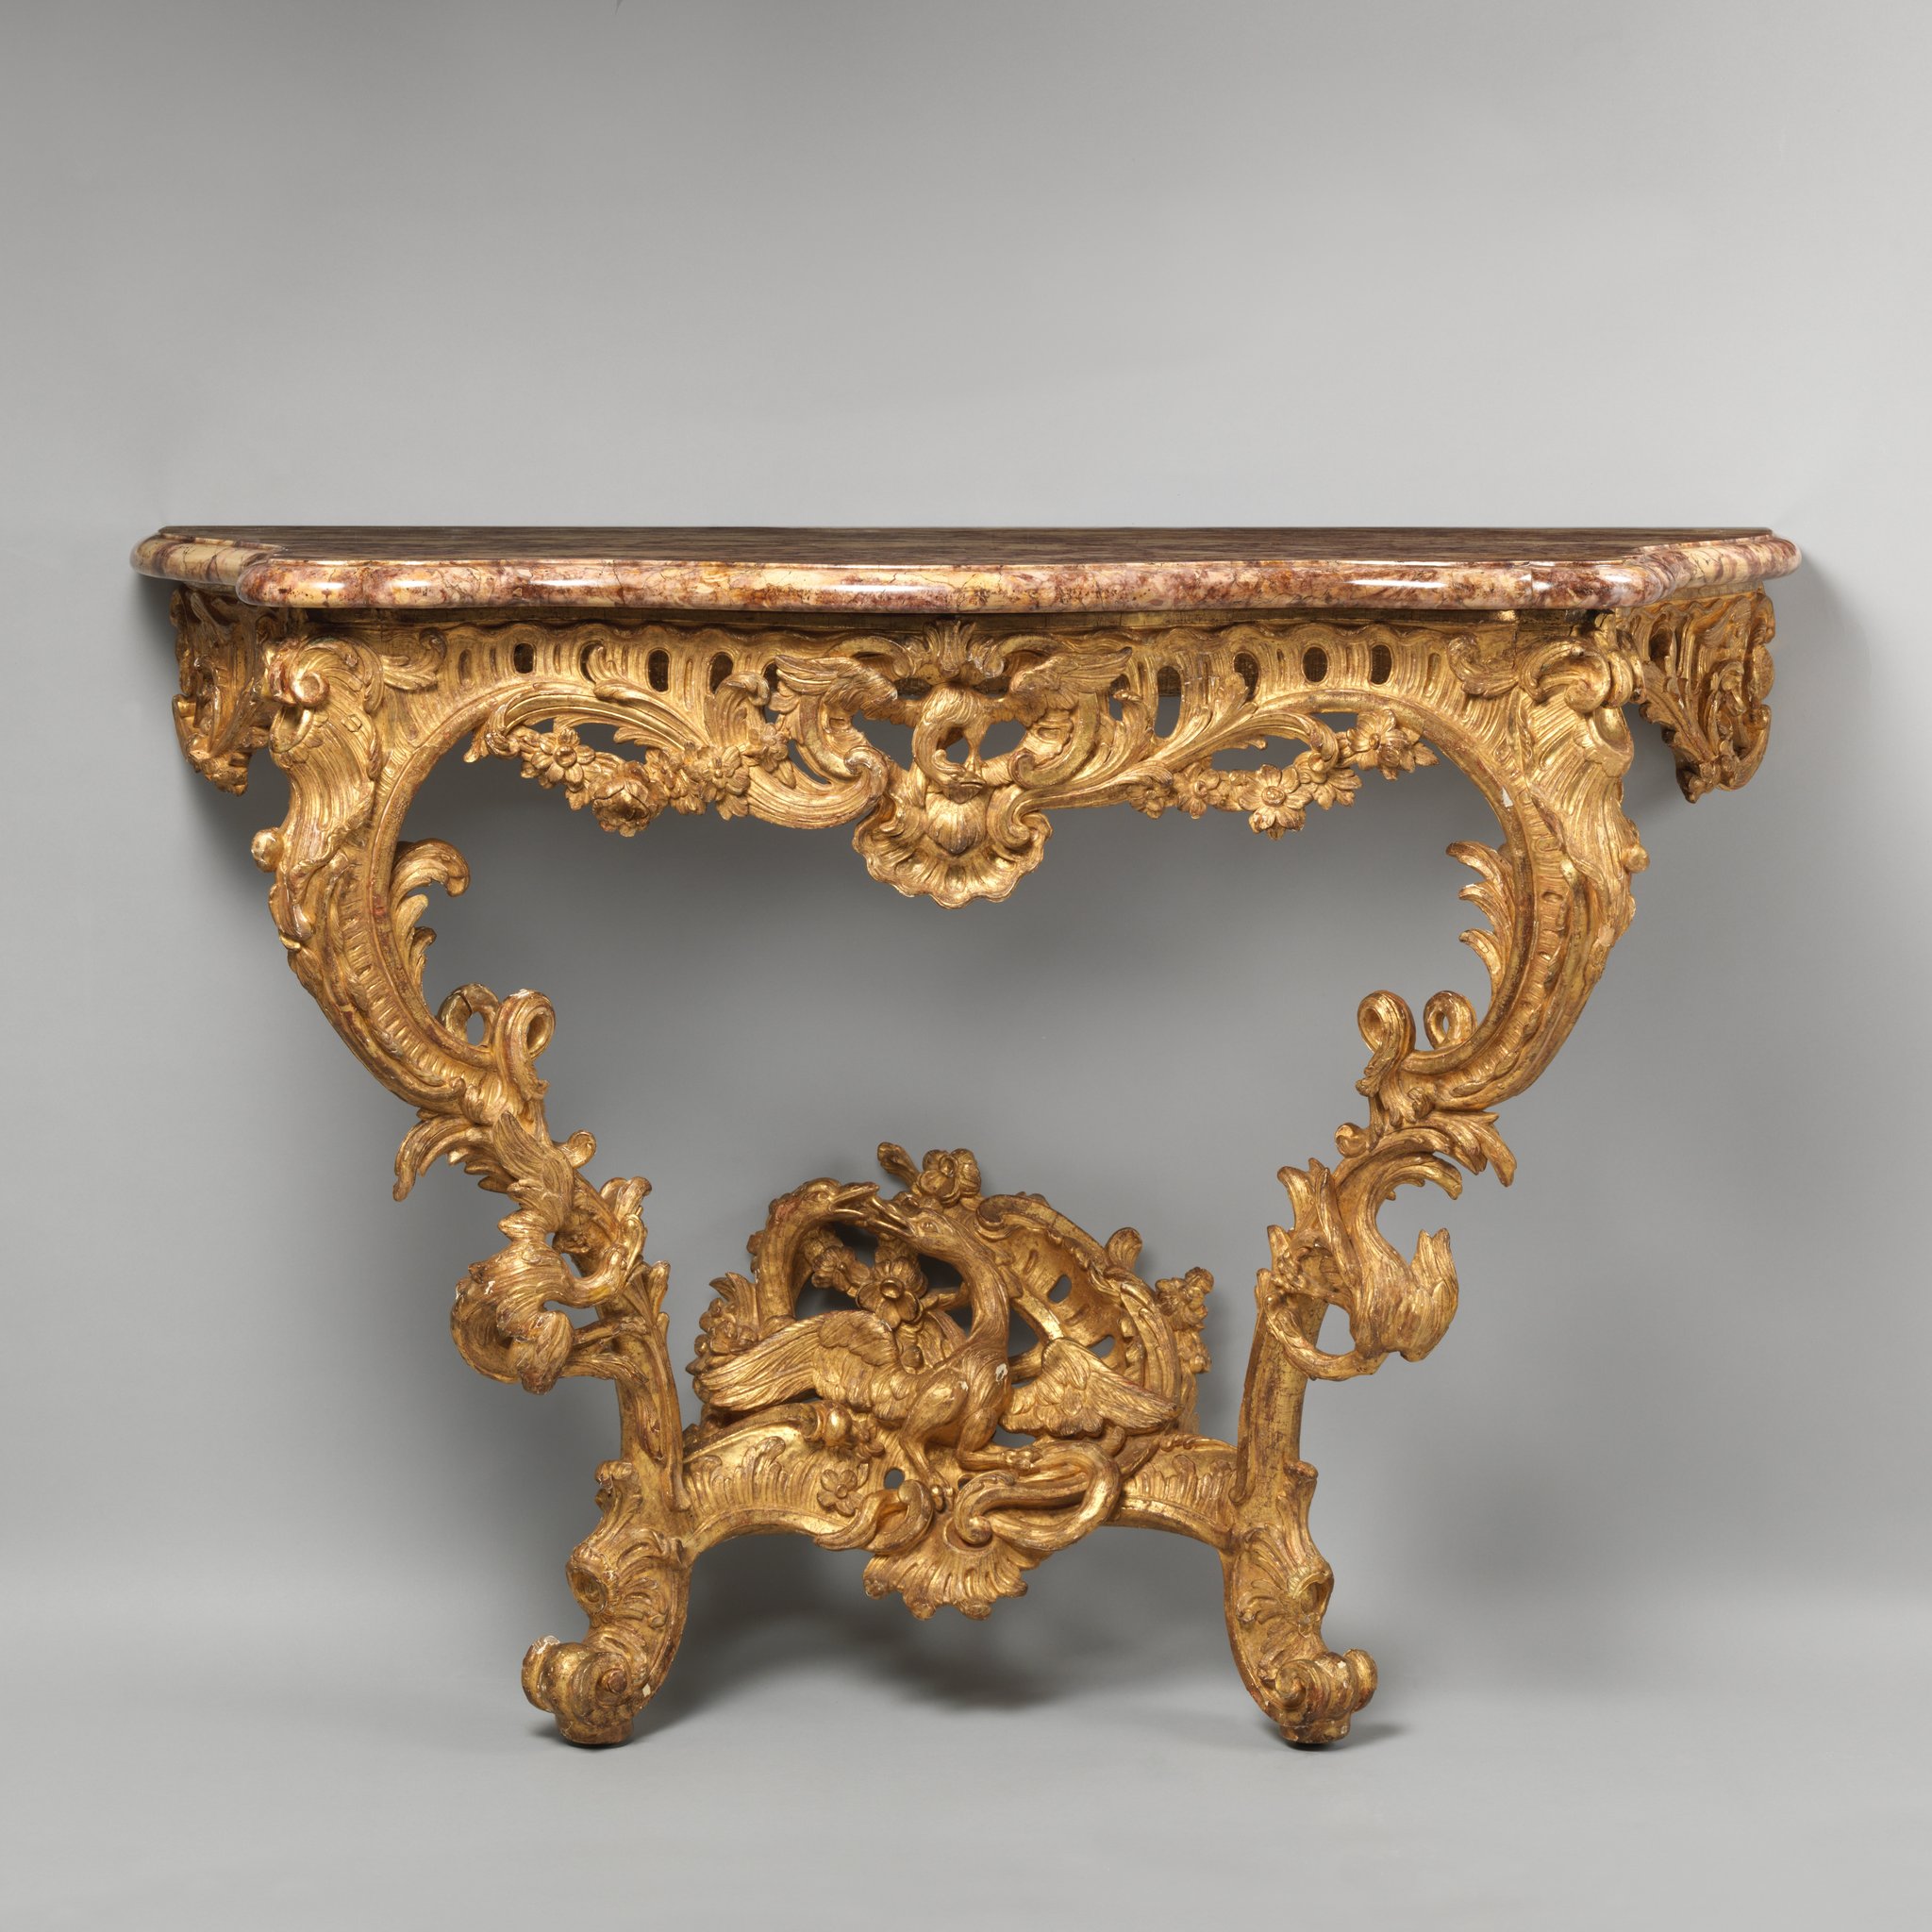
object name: console table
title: Console table (one of a pair)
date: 1735-1740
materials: marble, wood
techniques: carving, gilding